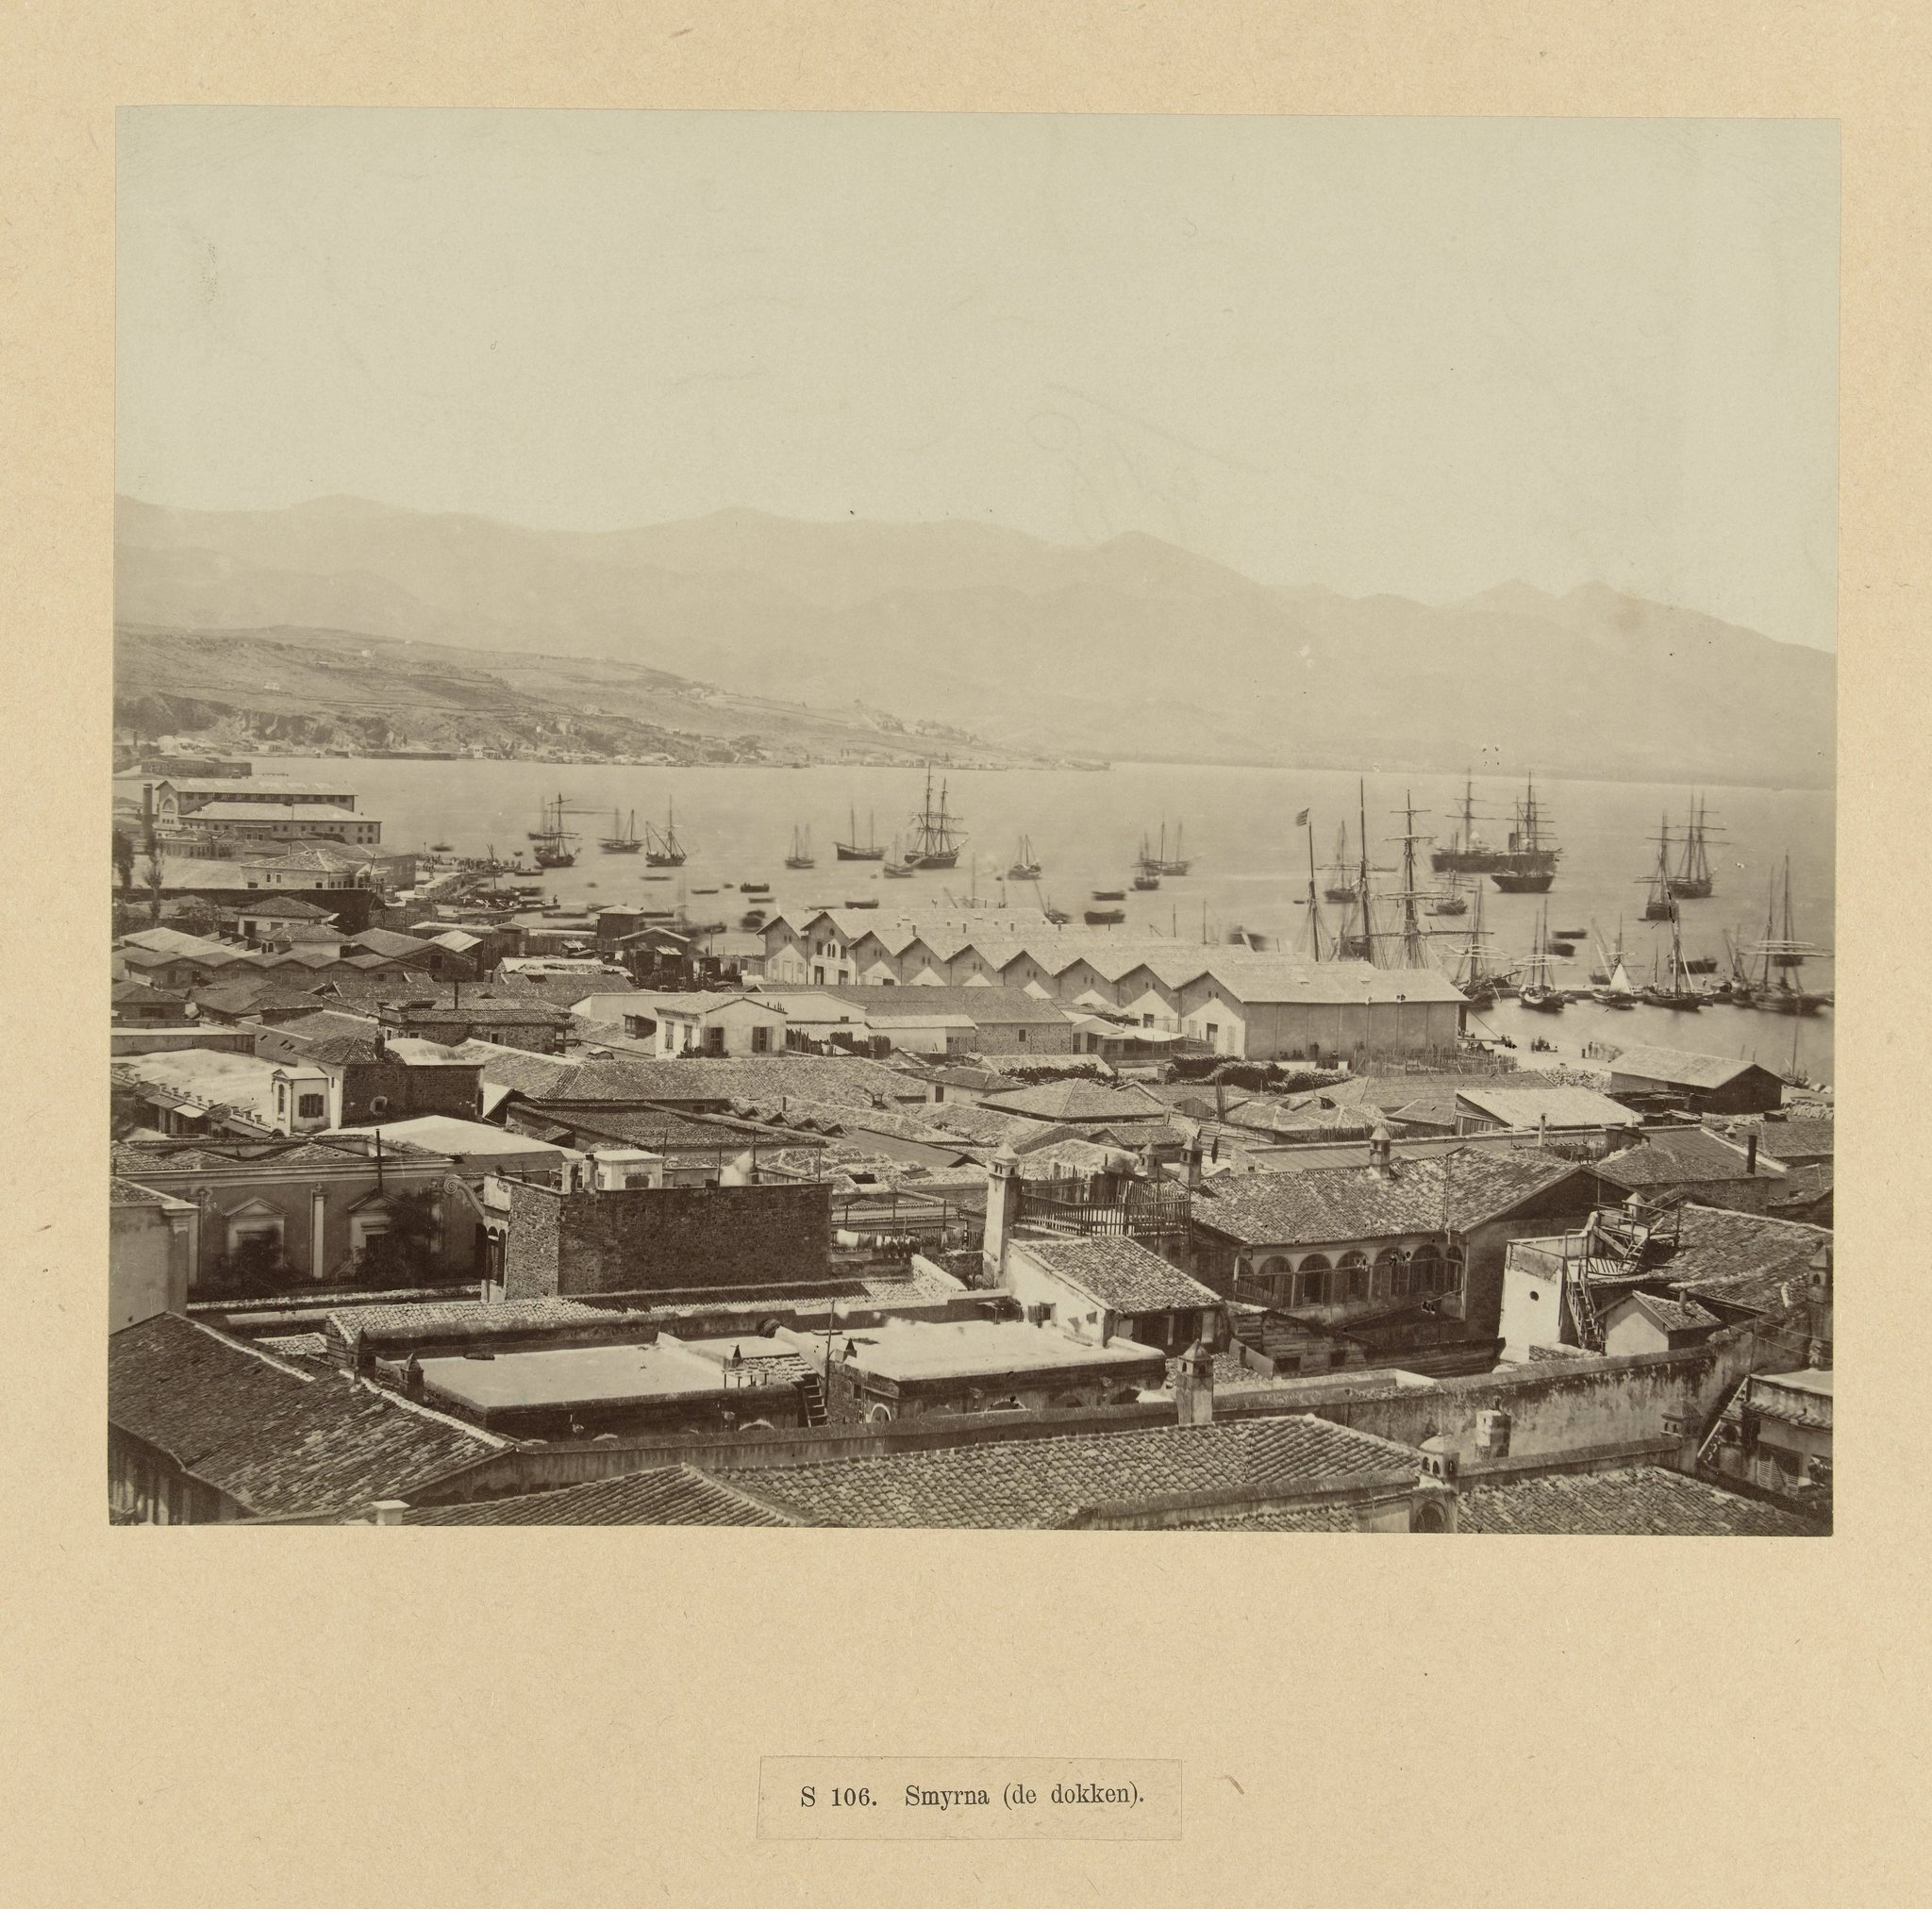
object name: photograph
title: Gezicht op de haven van Smyrna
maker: Anonymous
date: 1890-1895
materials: cardboard, paper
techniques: albumen print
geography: smyrna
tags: harbour, gulf, bay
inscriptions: title: ‘S 106. Smyrna (de dokken).’, stamp: ‘Gemeentelijke bibliotheek/ Rotterdam’, check stamp: ‘Bristol/ L.M.’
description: Onderdeel van een groep door fotograaf Richard Polak op reis verzamelde foto’s. Deze foto is samen met andere op zijn reizen verzamelde foto's tentoongesteld bij de Rotterdamsche Kunstkring (1895), Arti en Amicitiae te Amsterdam (1897-1898?) en Societeit 't Collegie te Kampen (datum vooralsnog onbekend).